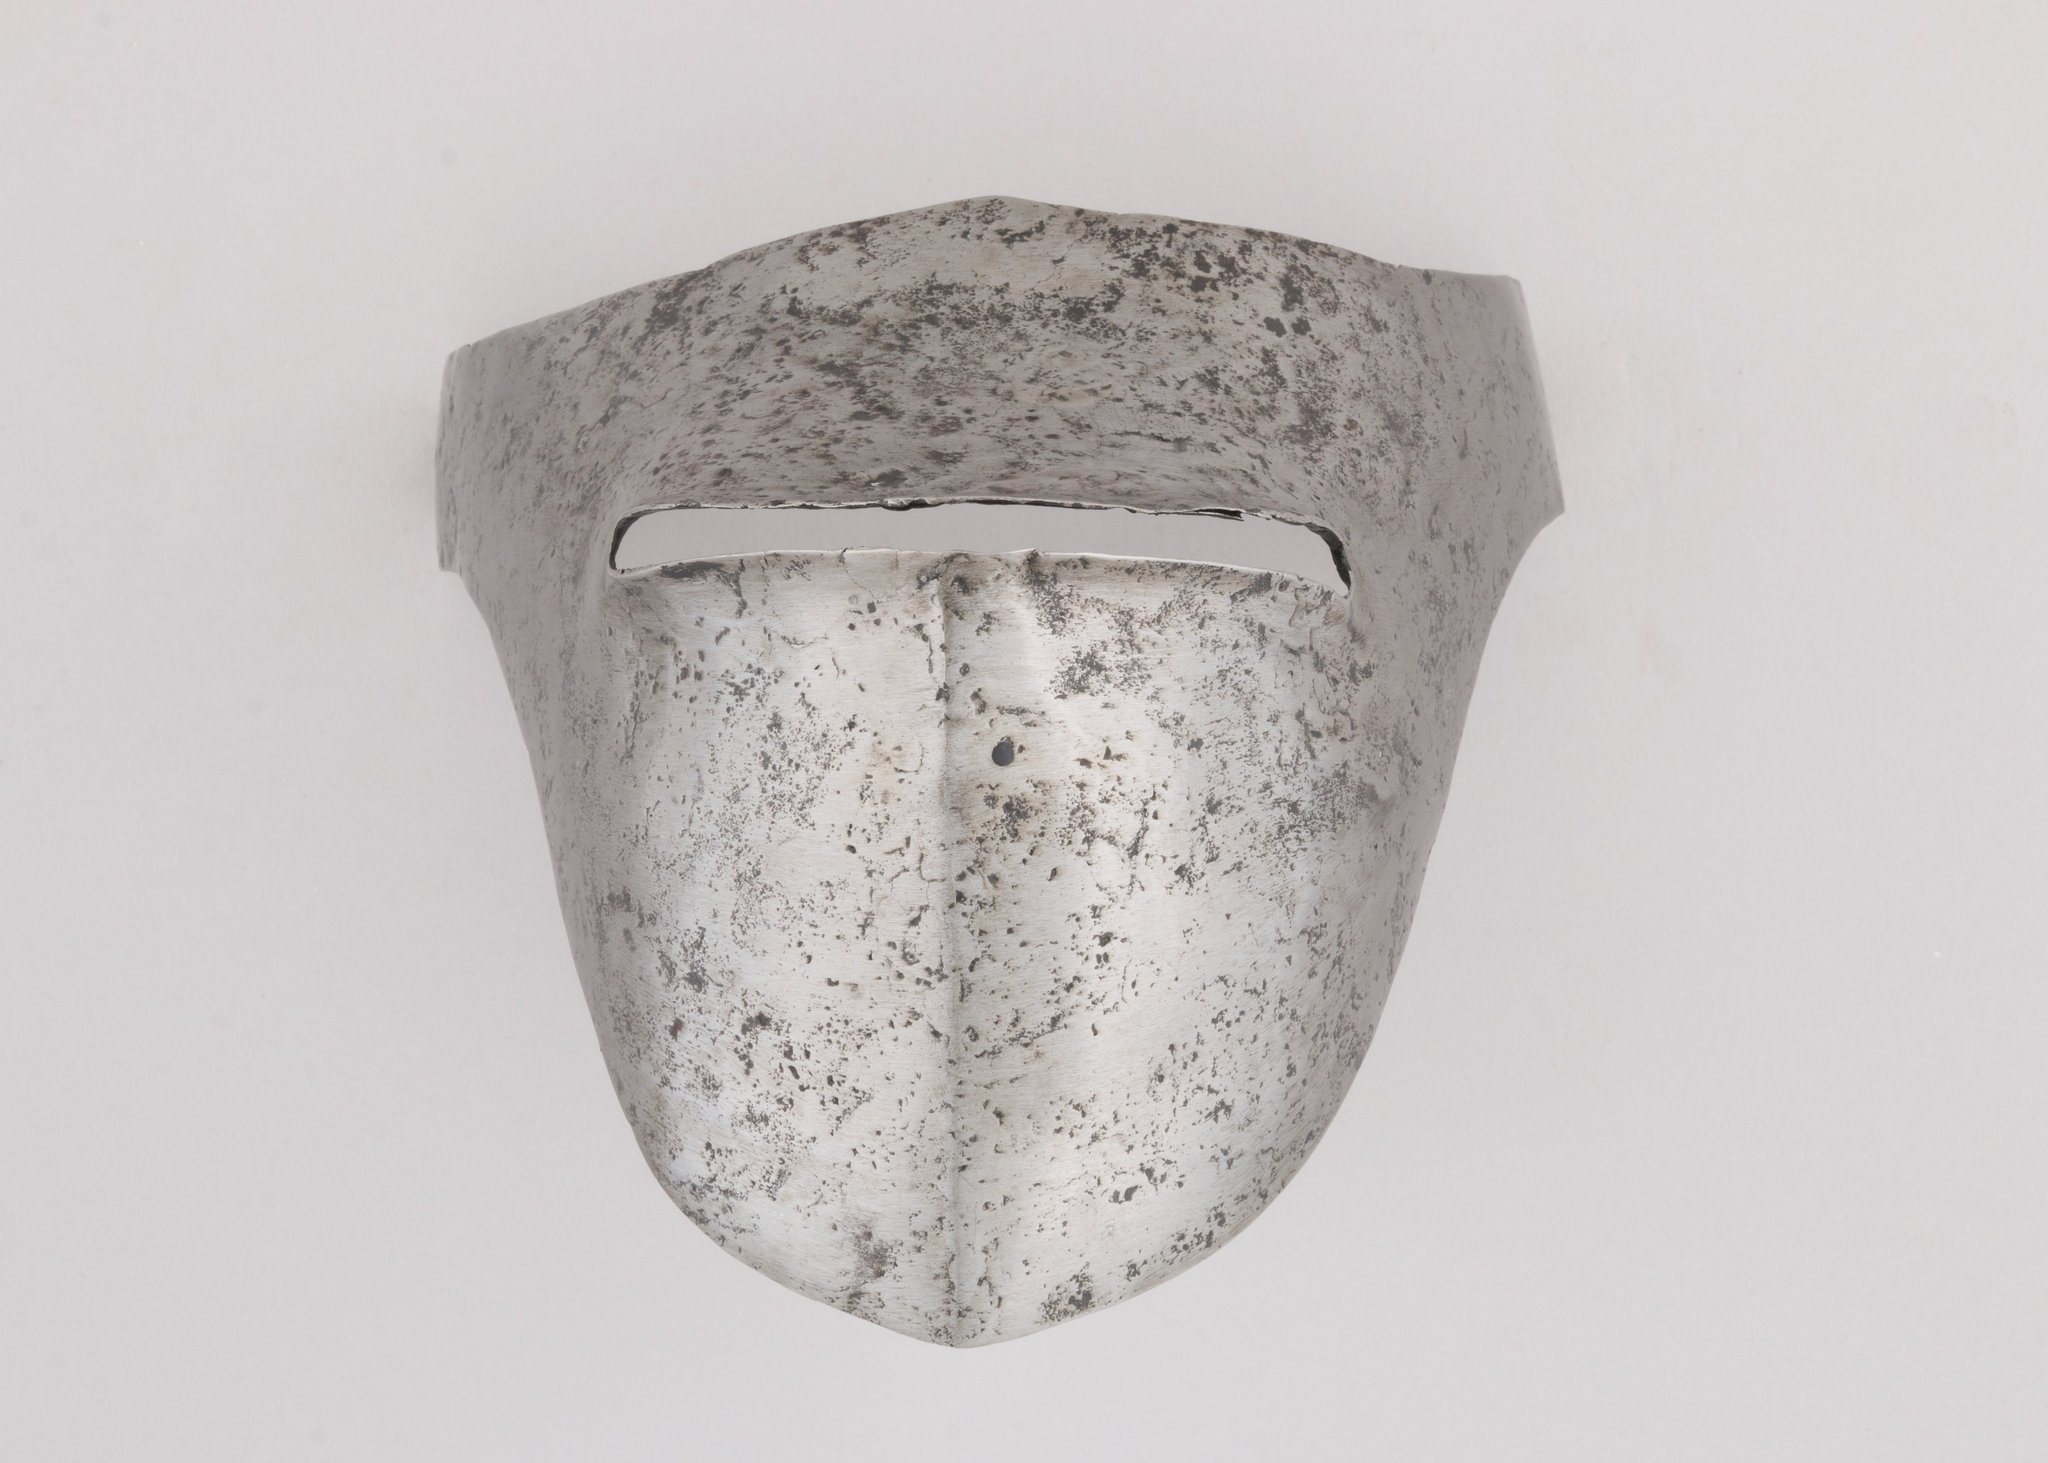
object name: visor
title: Visor for a Bascinet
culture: italian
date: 1430-1450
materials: steel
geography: italy